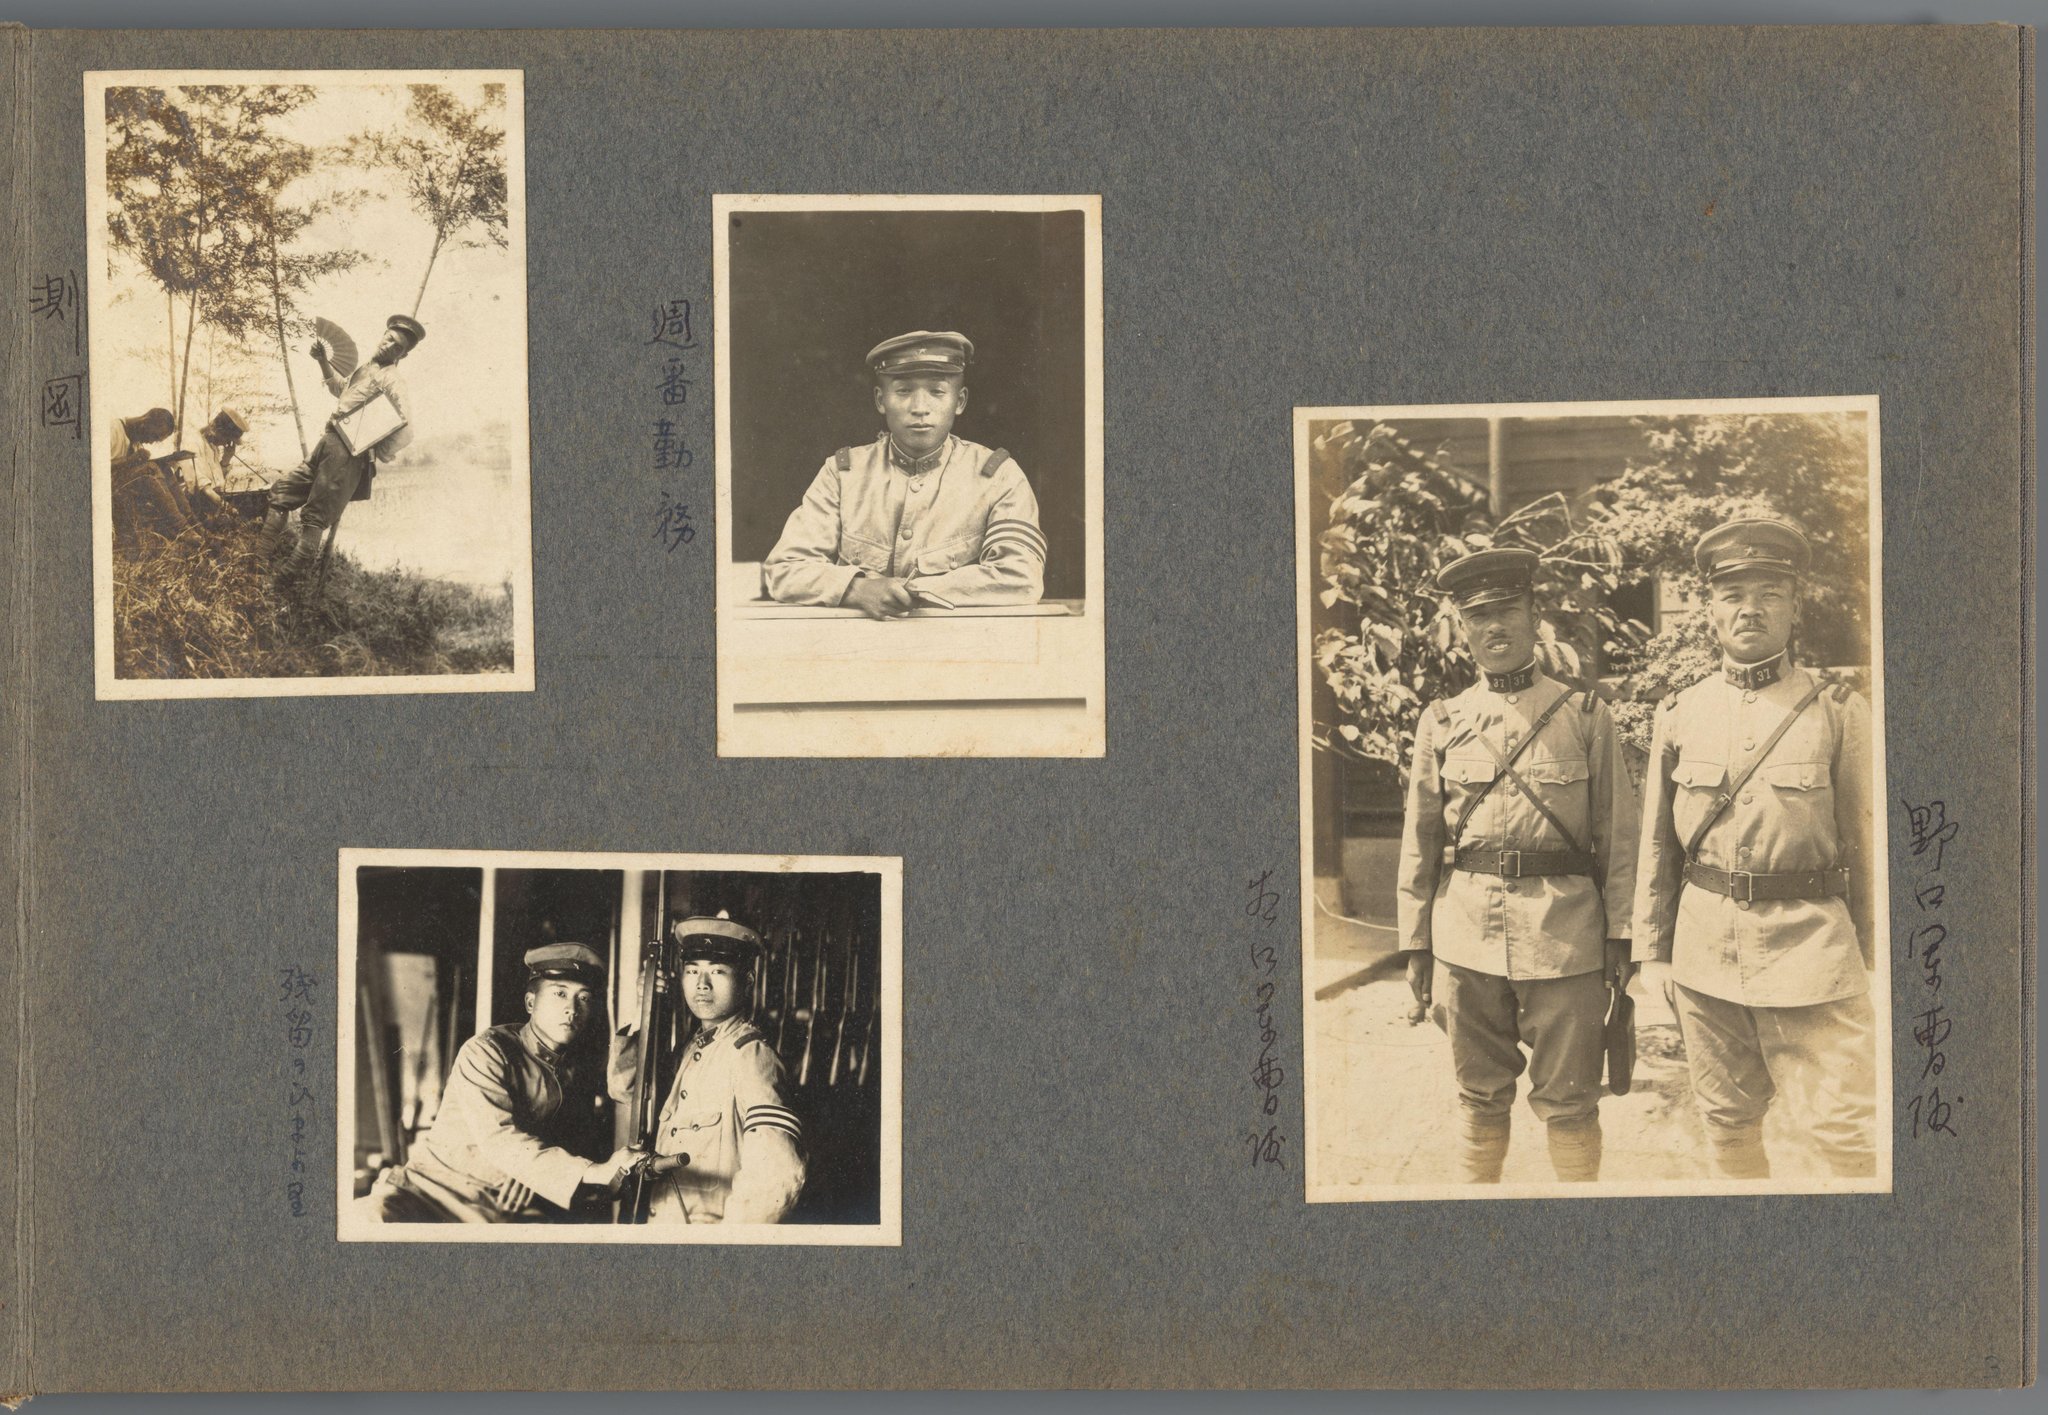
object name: album leaf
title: Portretten van medesoldaten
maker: Anonymous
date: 1930-1940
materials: cardboard, photographic support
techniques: gelatin silver print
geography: japan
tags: military training, japan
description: Albumblad met vier foto's van het leven van Japanse militairen. Bij de foto's opschriften in het Japans. Onderdeel van het leporello fotoalbum met foto’s van de diensttijd van Japanse militairen.